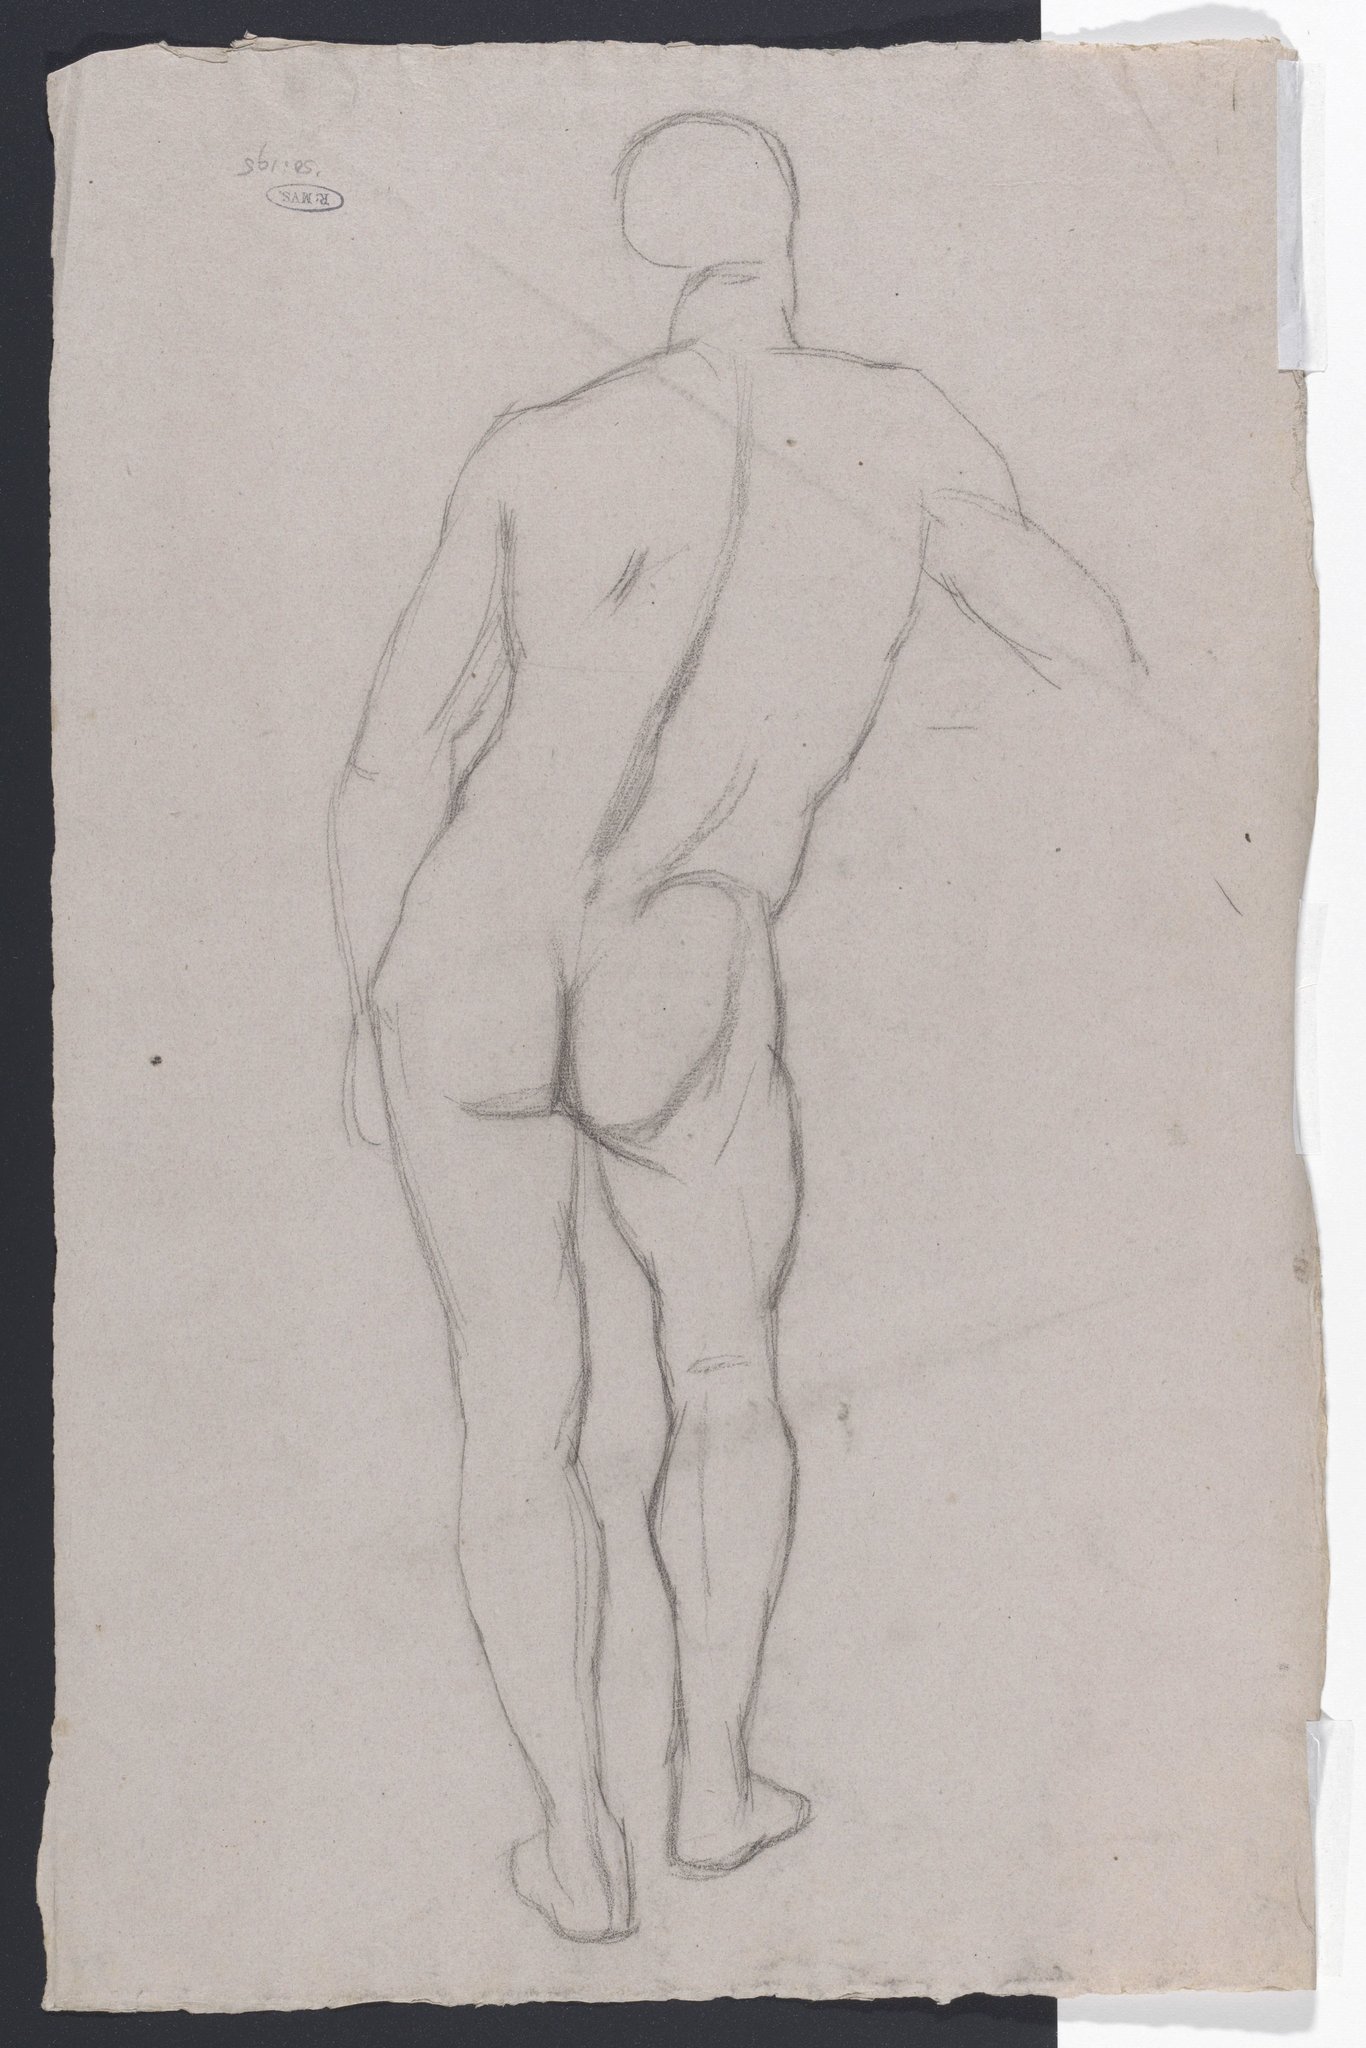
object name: drawing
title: Schets van een mannelijk naakt, van achteren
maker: august allebé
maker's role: draughtsman, print maker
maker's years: 1838-1927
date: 1848-1927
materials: chalk, paper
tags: the (nude) human figure; 'corpo humano' (ripa)